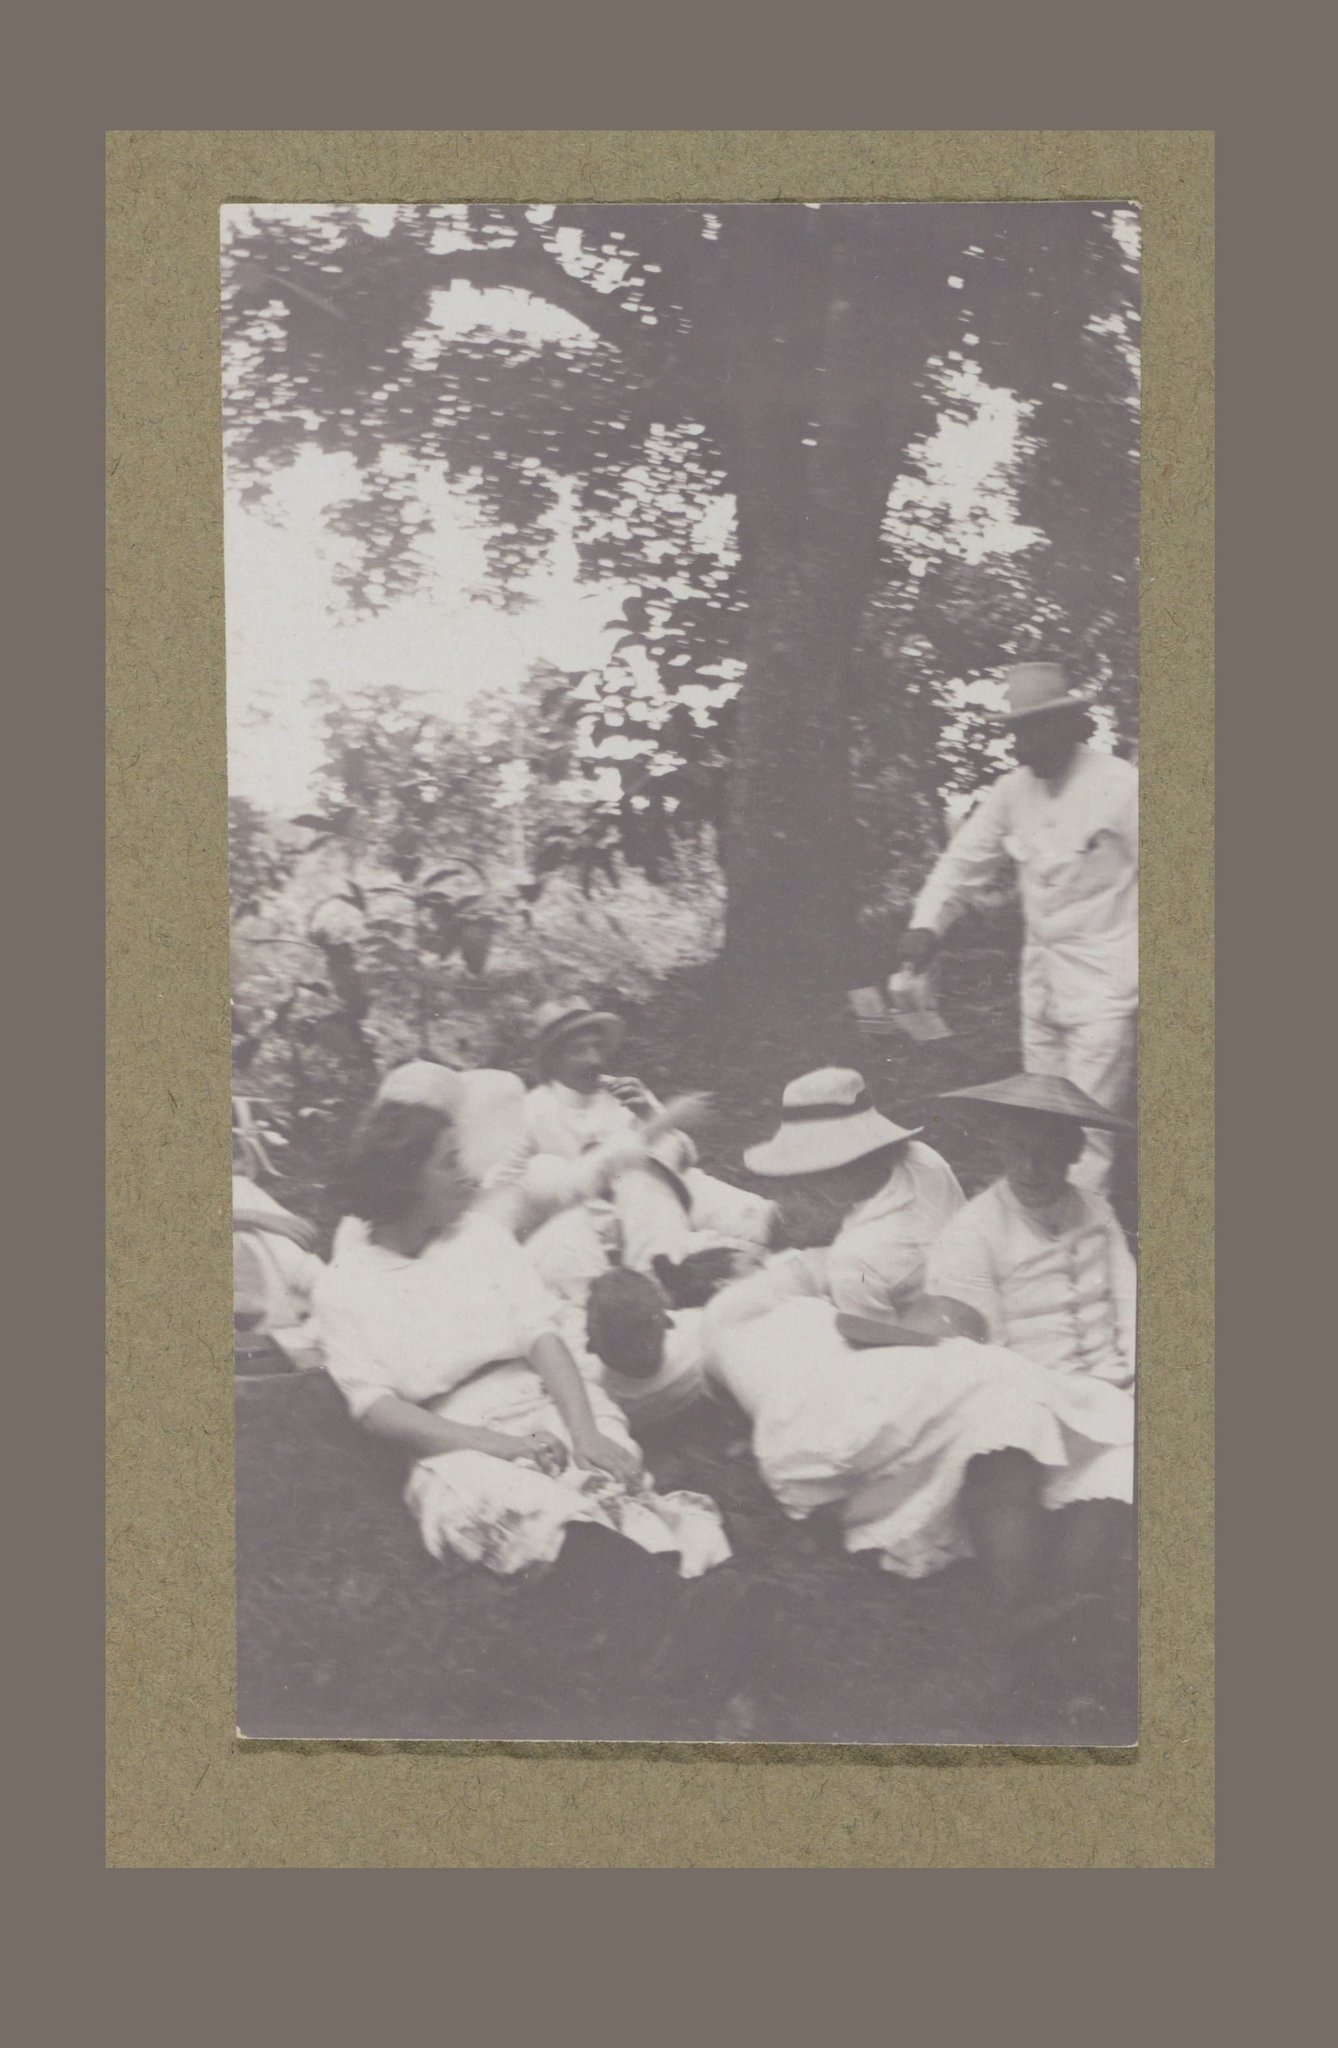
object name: photograph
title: Picknick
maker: Anonymous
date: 1912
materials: photographic support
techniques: photography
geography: suriname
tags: tennis, lawn-tennis, picnic, alfresco, 'déjeuner sur l'herbe', suriname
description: Picknick onder een boom, met leden van de familie Gonggrijp. Onderdeel van het fotoalbum over het leven van de familie Gonggrijp in Suriname rond 1912.